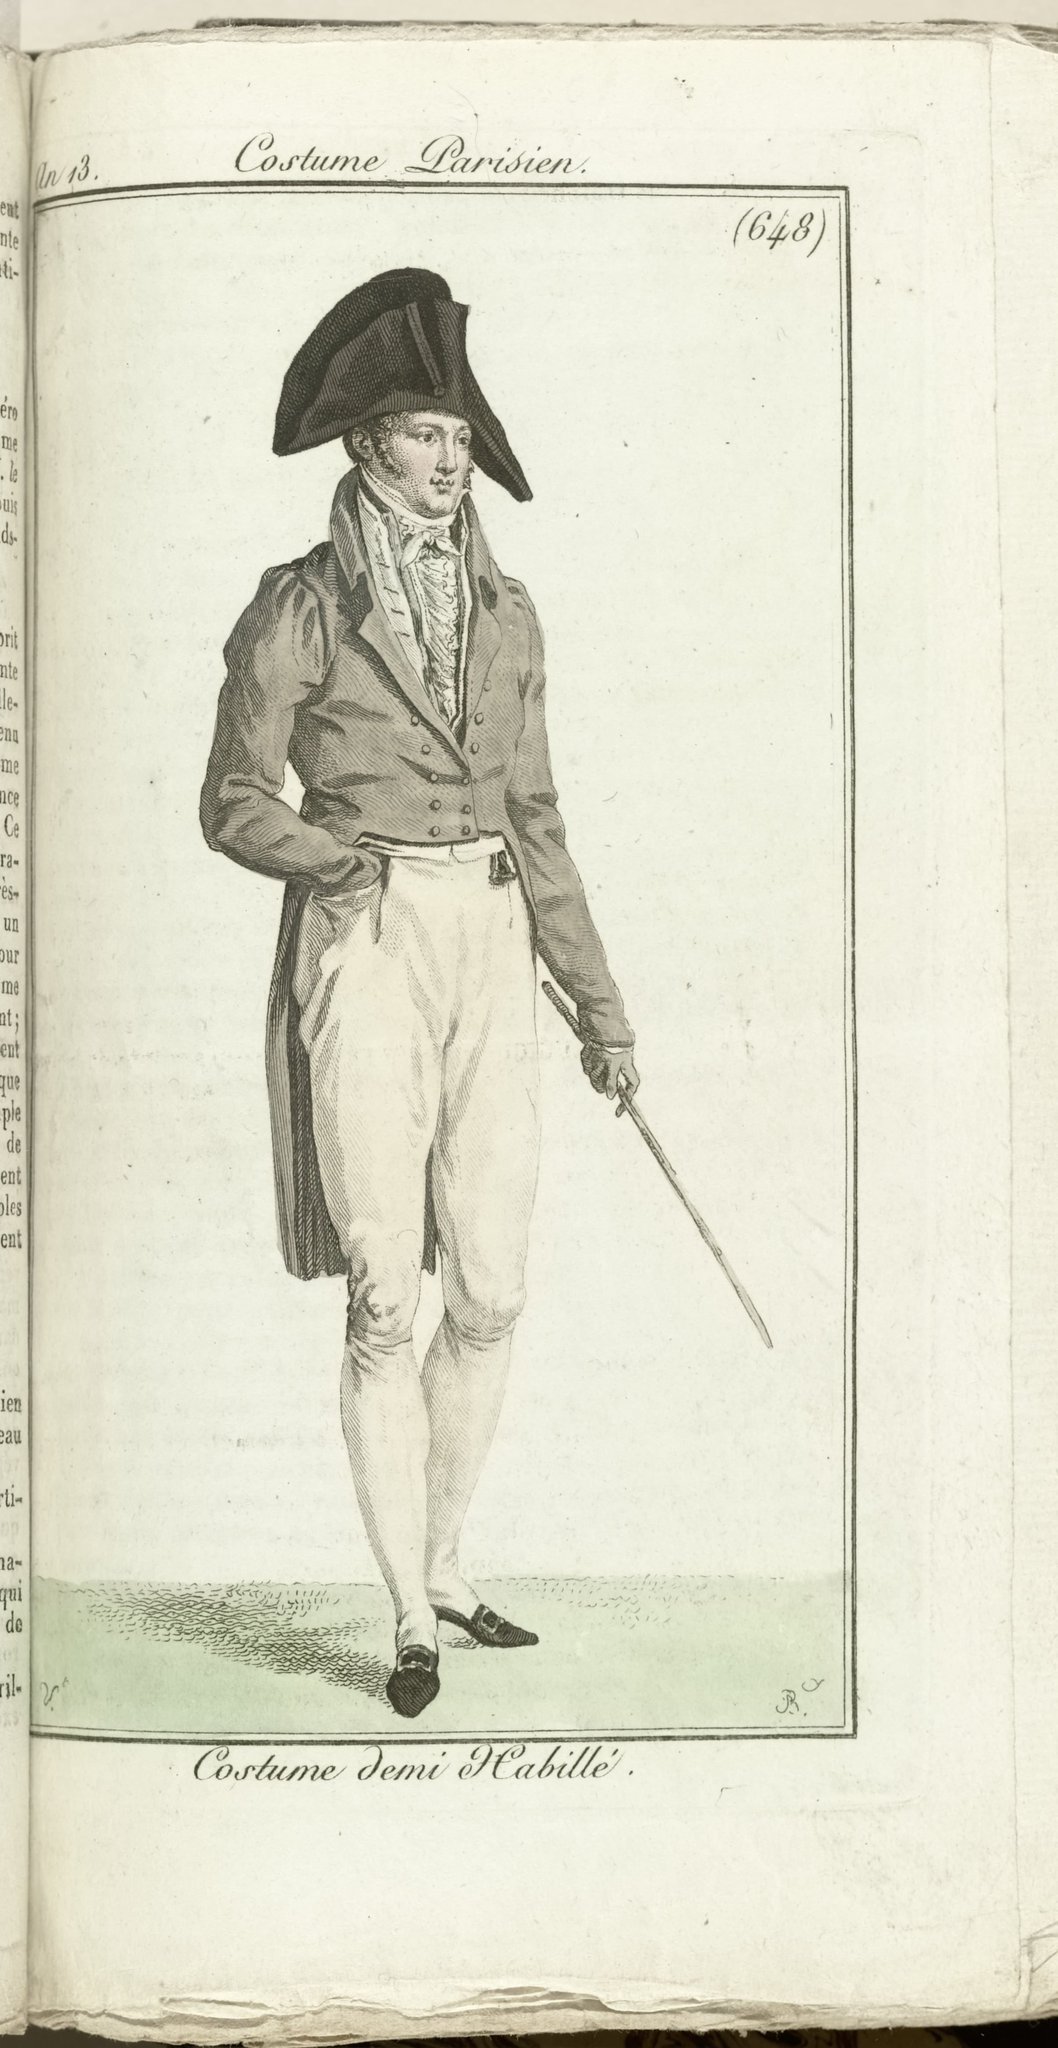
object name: fashion print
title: Journal des Dames et des Modes, Costume Parisien, 1805, An 13 (648) Costume demi Habillé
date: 1805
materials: paper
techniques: engraving, hand coloring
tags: clothing for the upper part of the body (vest) (+ men's clothes), coat (+ men's clothes), fashion plates, trousers, breeches, etc. (breeches) (+ men's clothes), stockings, socks (+ men's clothes), walking-stick, staff, cane (+ men's clothes), head-gear: bicorne, bicorn (+ men's clothes)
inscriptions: title: ‘Costume demi Habillé’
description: Staande man naar rechts, gekleed in een 'costume demi habillé': frak met twee rijen knopen, vest en kniebroek. Hemd met gerimpelde jabot. Cravate. Kousen. Accessoires: steek met knoop en lis, handschoen, wandelstok, platte schoenen met vierkante gespen. De prent maakt deel uit van het modetijdschrift Journal des Dames et des Modes, uitgegeven door Pierre de la Mésangère, Parijs, 1797-1839.